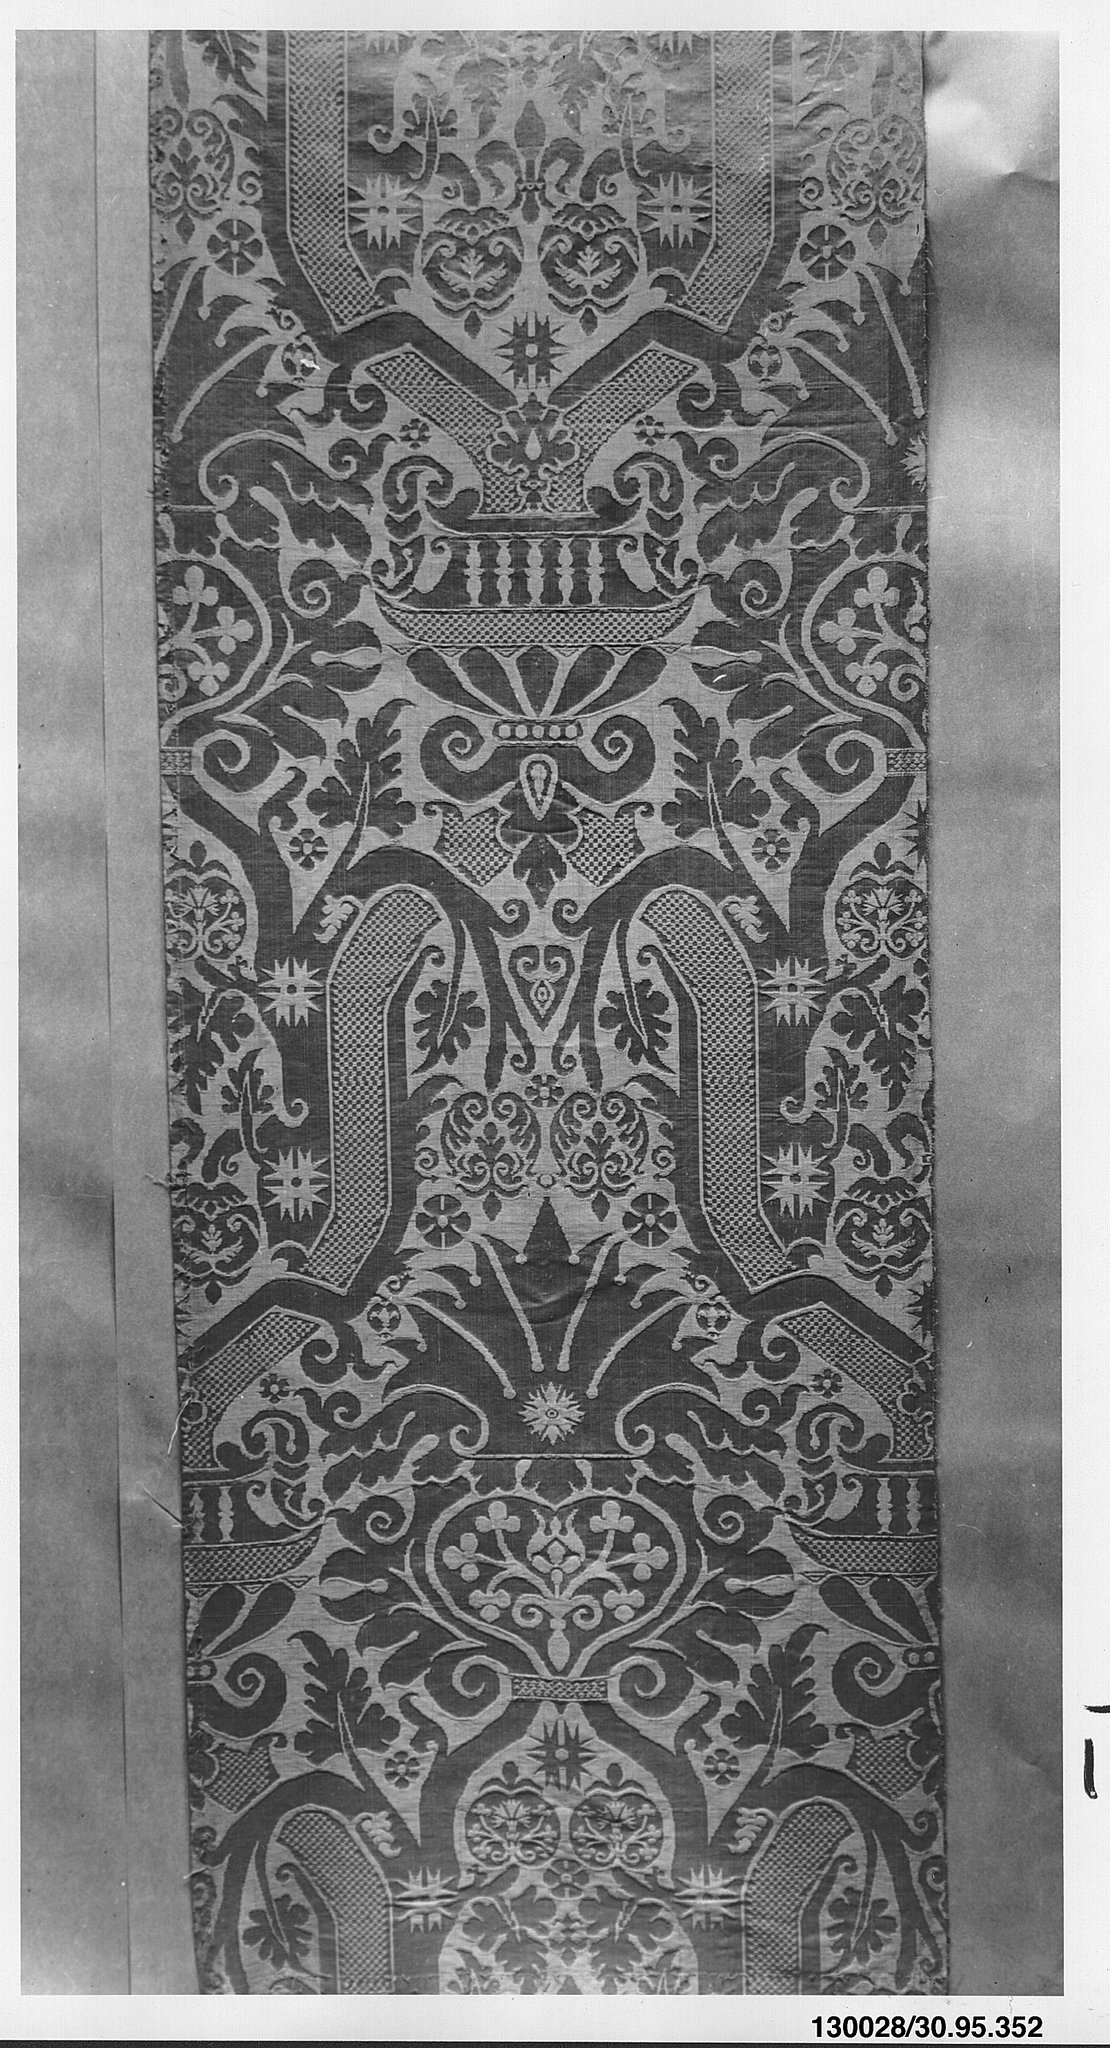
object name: piece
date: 1601-1700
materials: silk